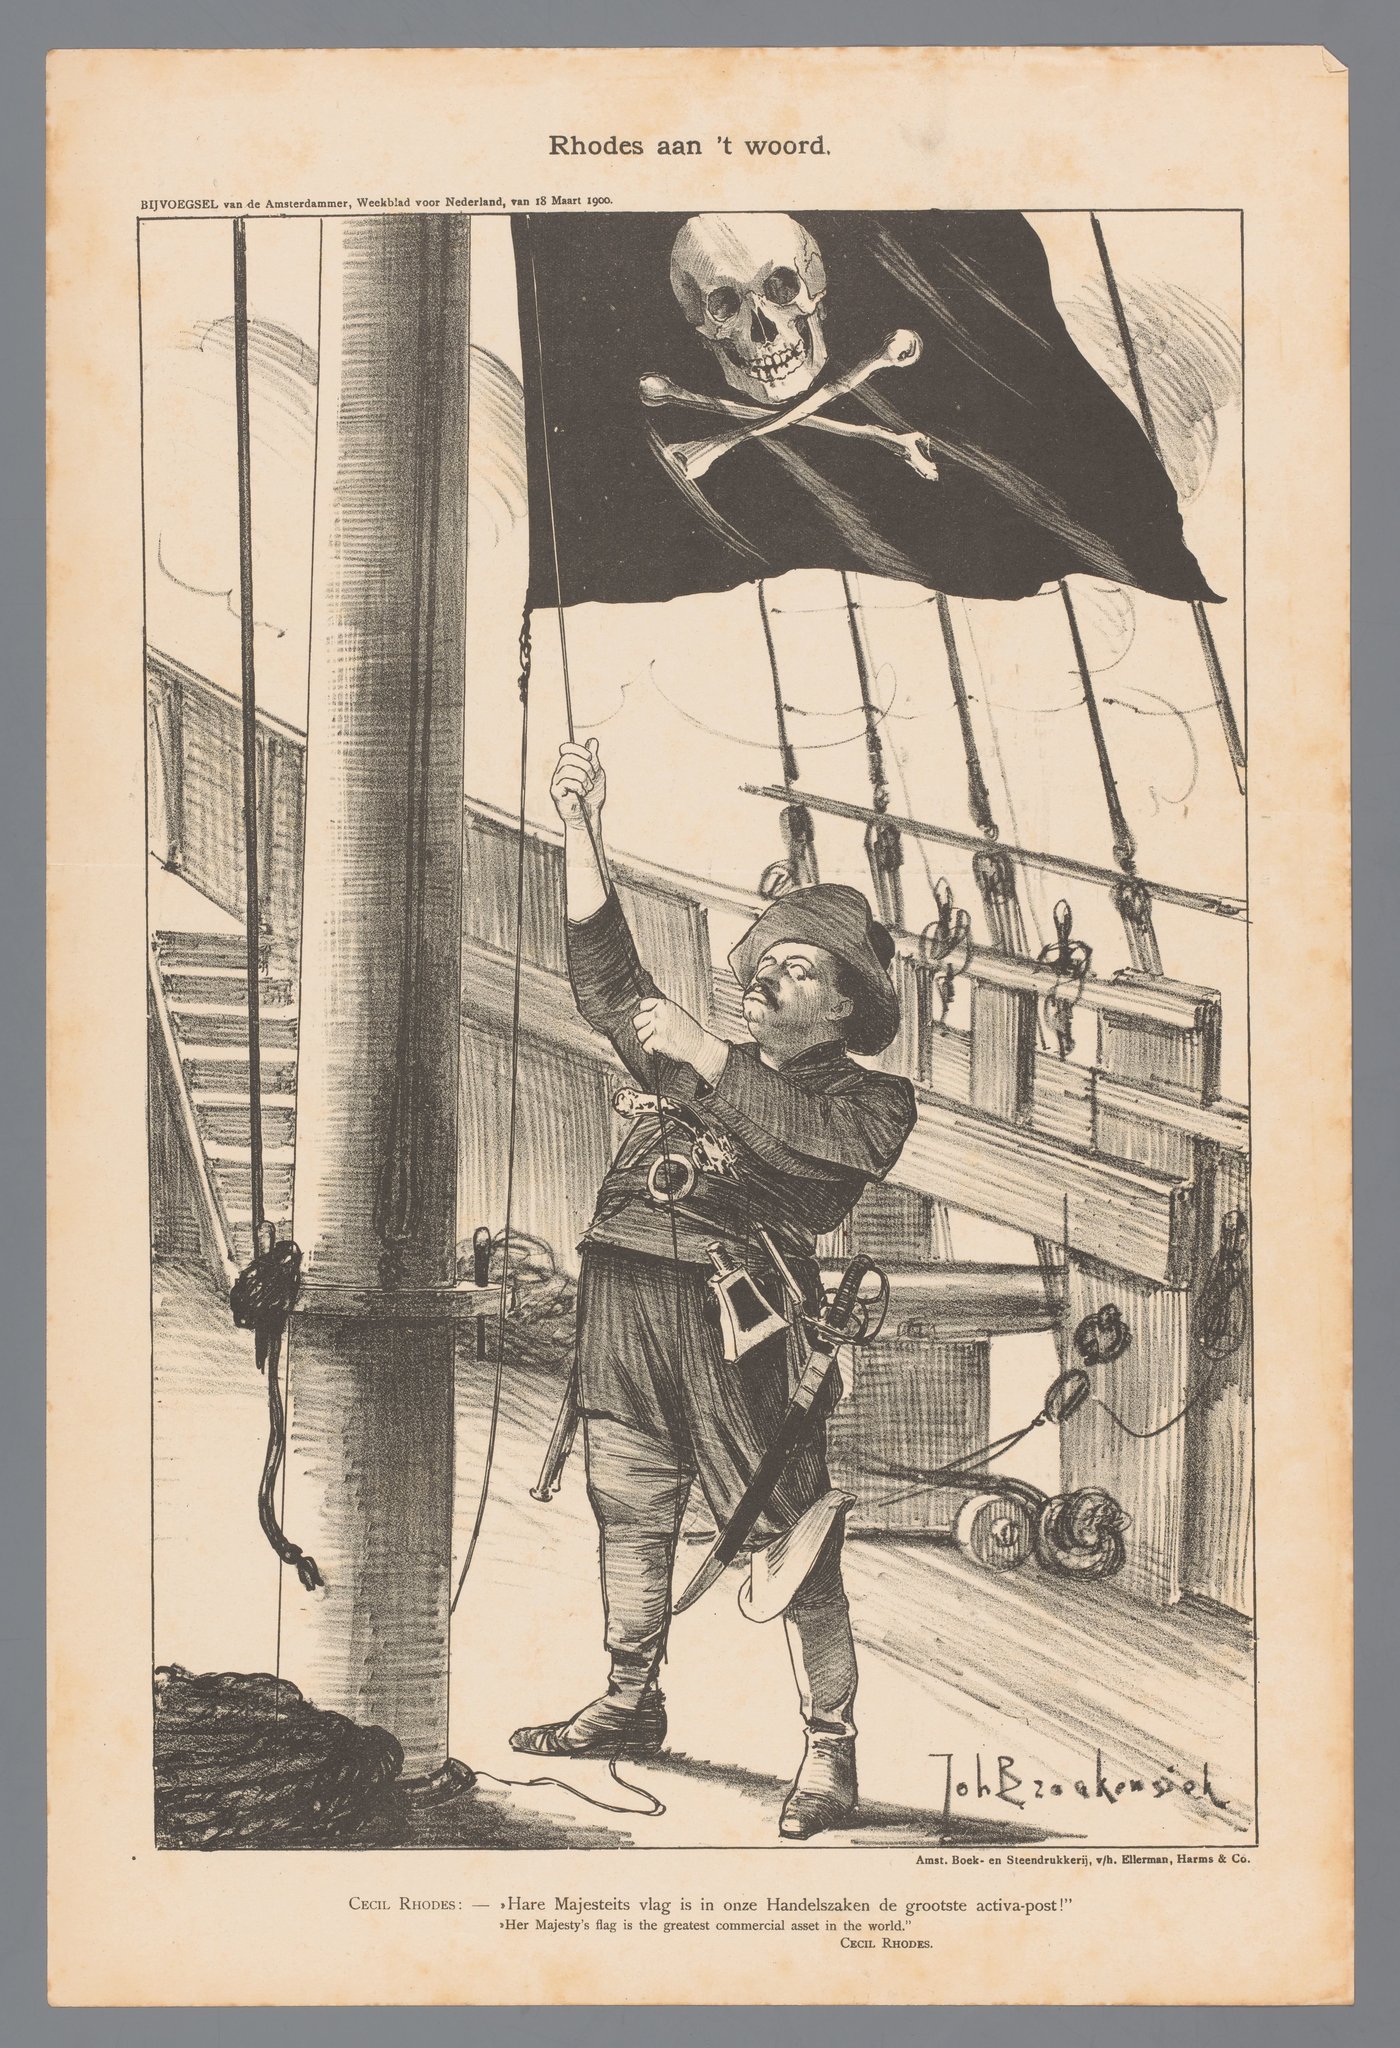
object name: cartoon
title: Rhodes aan 't woord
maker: johan braakensiek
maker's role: draughtsman, print maker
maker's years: 1858-1940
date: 1900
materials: paper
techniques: lithograph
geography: amsterdam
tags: historical persons, political caricatures and satires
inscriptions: date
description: Prent uit het bijvoegsel van: De Amsterdammer. Weekblad voor Nederland, 18 maart 1900.